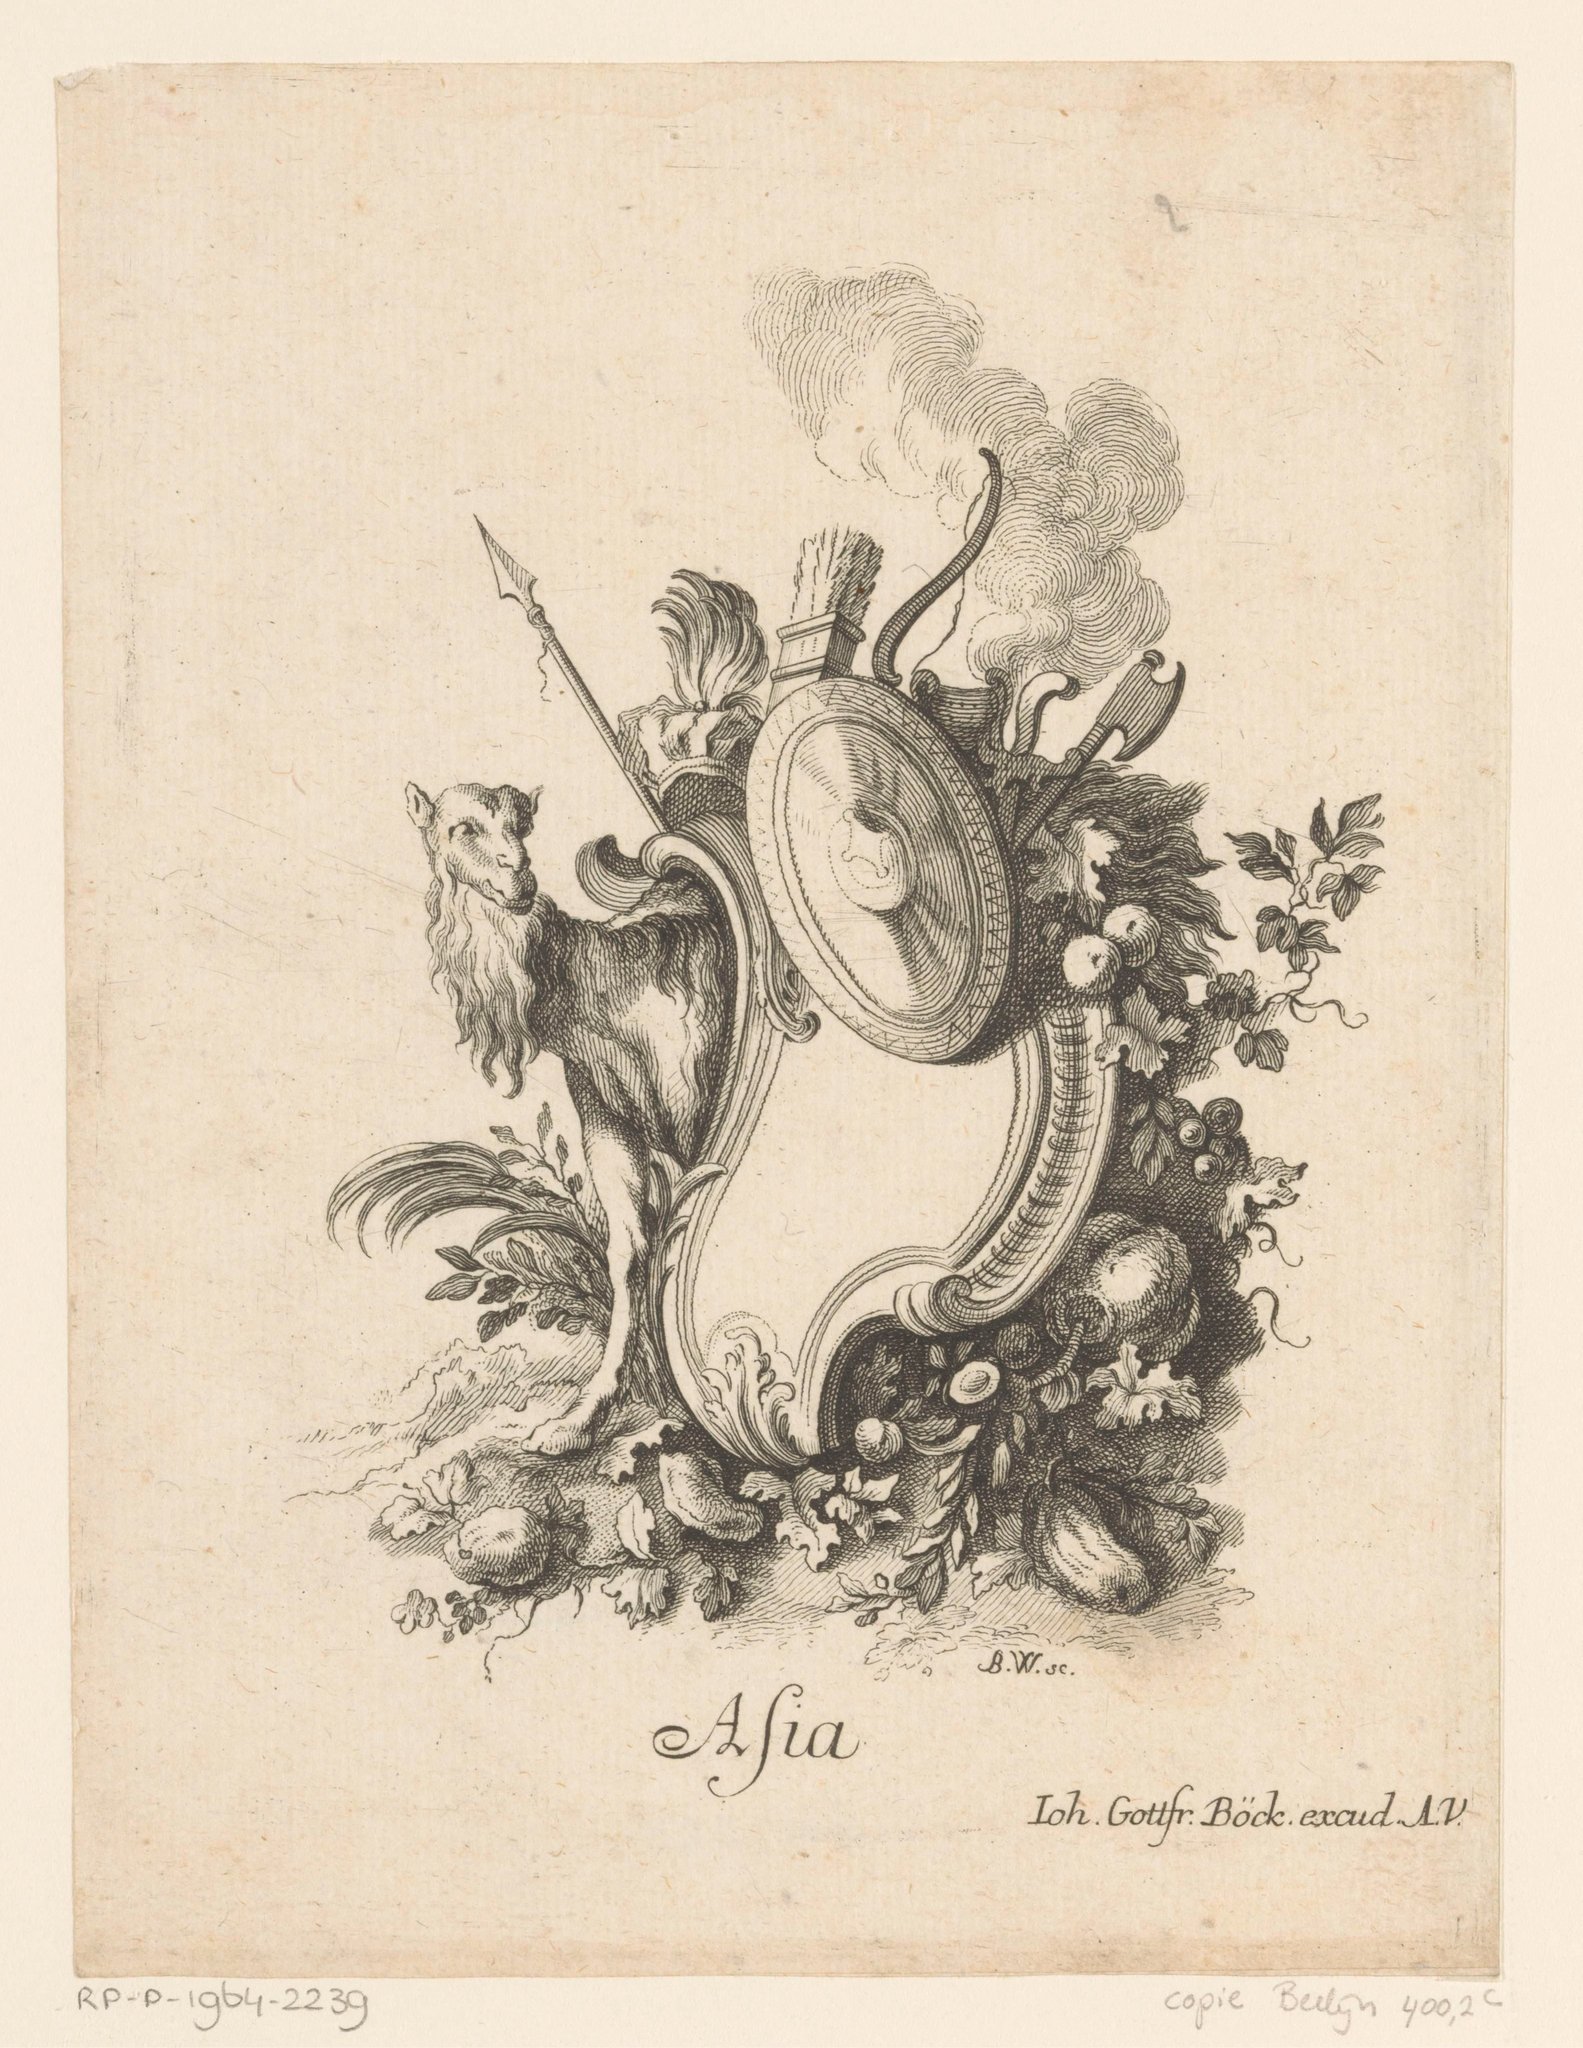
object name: print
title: Azië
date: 1750-1770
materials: paper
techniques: etching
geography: augsburg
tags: asia represented allegorically; 'asia' (ripa), ornament ~ cartouche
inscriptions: collector's mark: Lugt 2228, collector's mark: Lugt 2760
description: Links van een cartouche staat een kameel of dromedaris. Bovenop het cartouche liggen enkele wapens en een schild, rechts daarvan fruit.